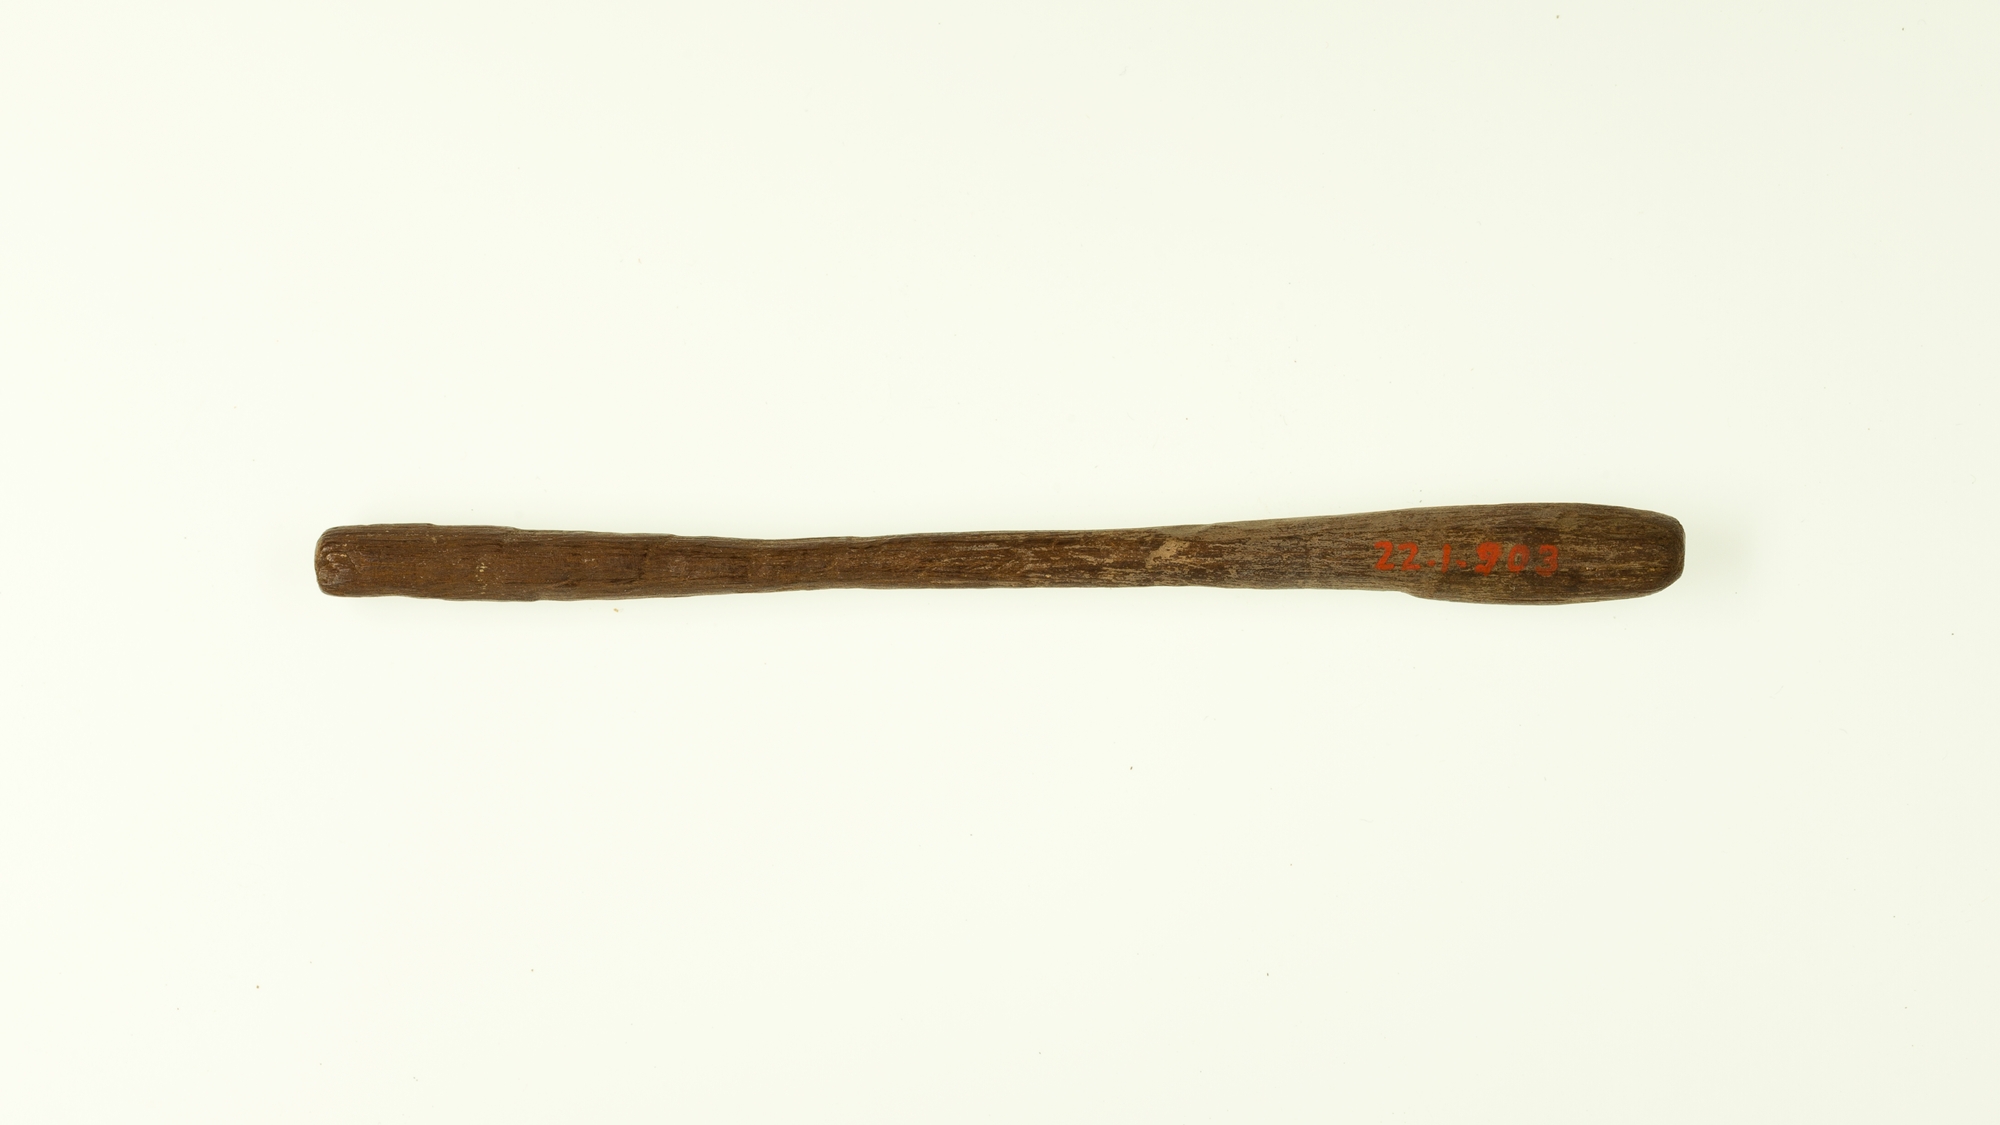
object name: kohl stick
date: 1295-1070 BCE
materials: wood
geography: egypt